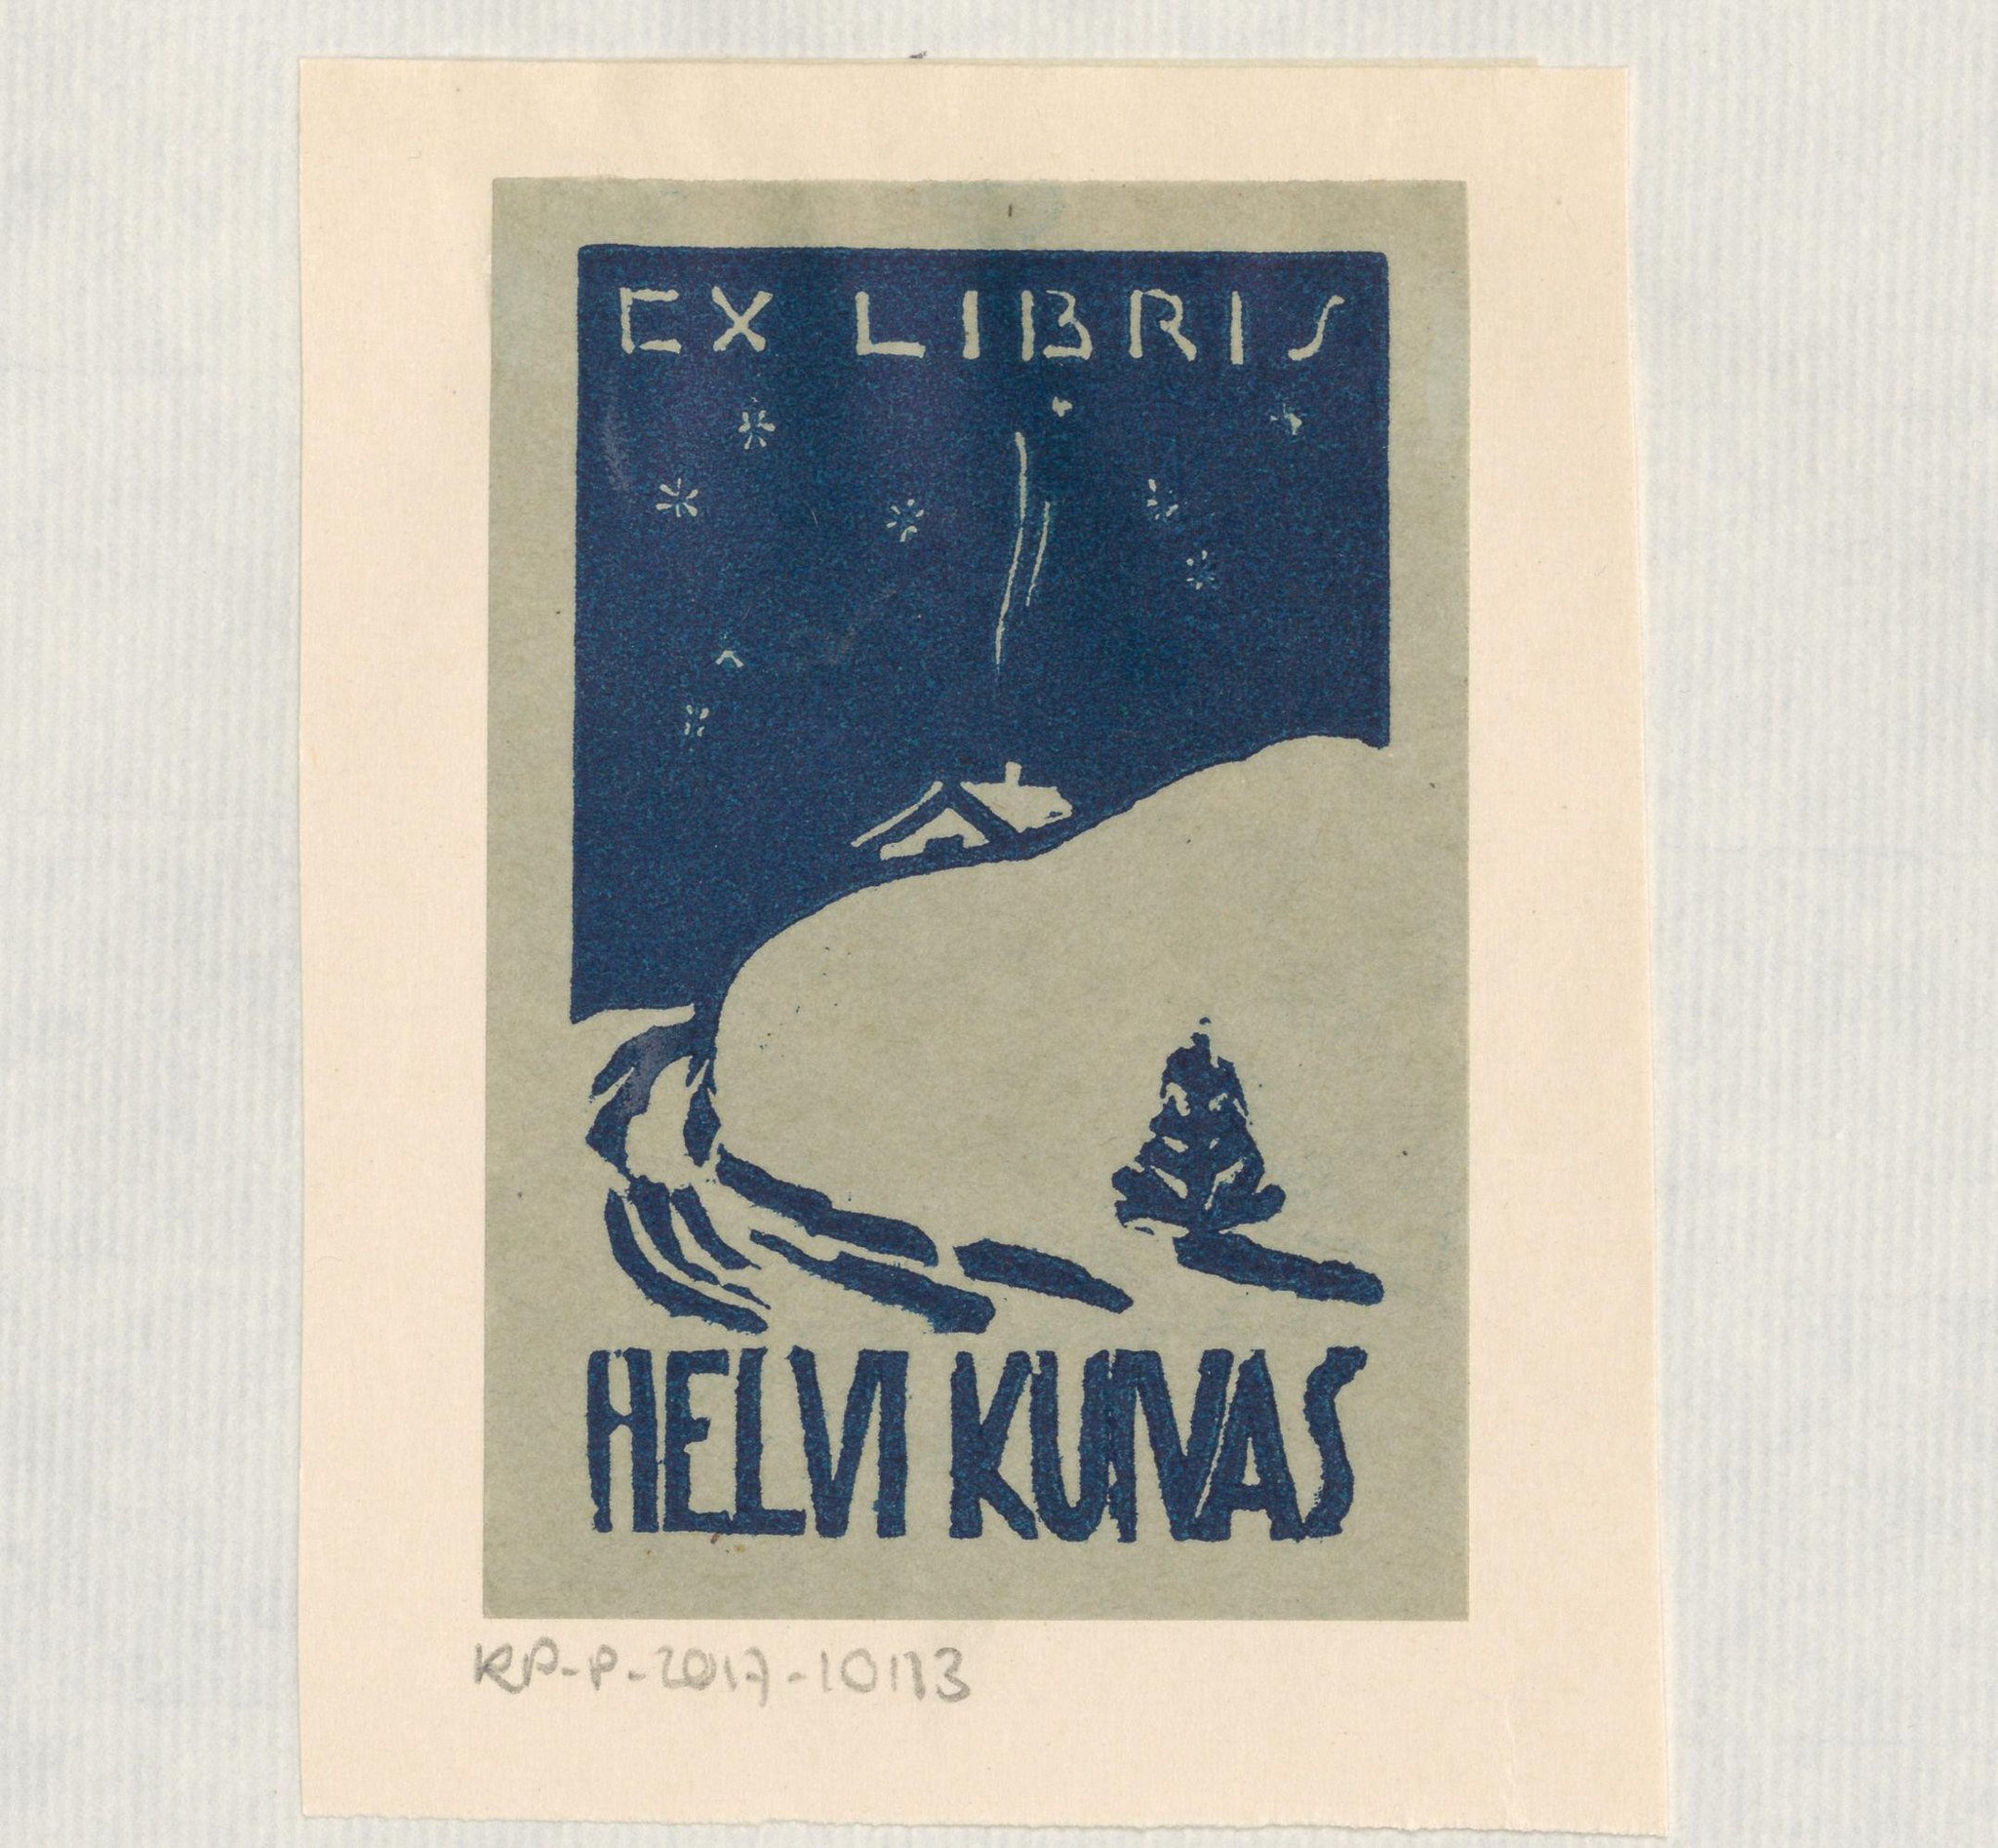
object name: bookplate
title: Ex libris van Helvi Kuivas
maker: pekka törmä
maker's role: print maker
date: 1946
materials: paper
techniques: linocut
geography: finland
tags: low hill country, housing, road, path